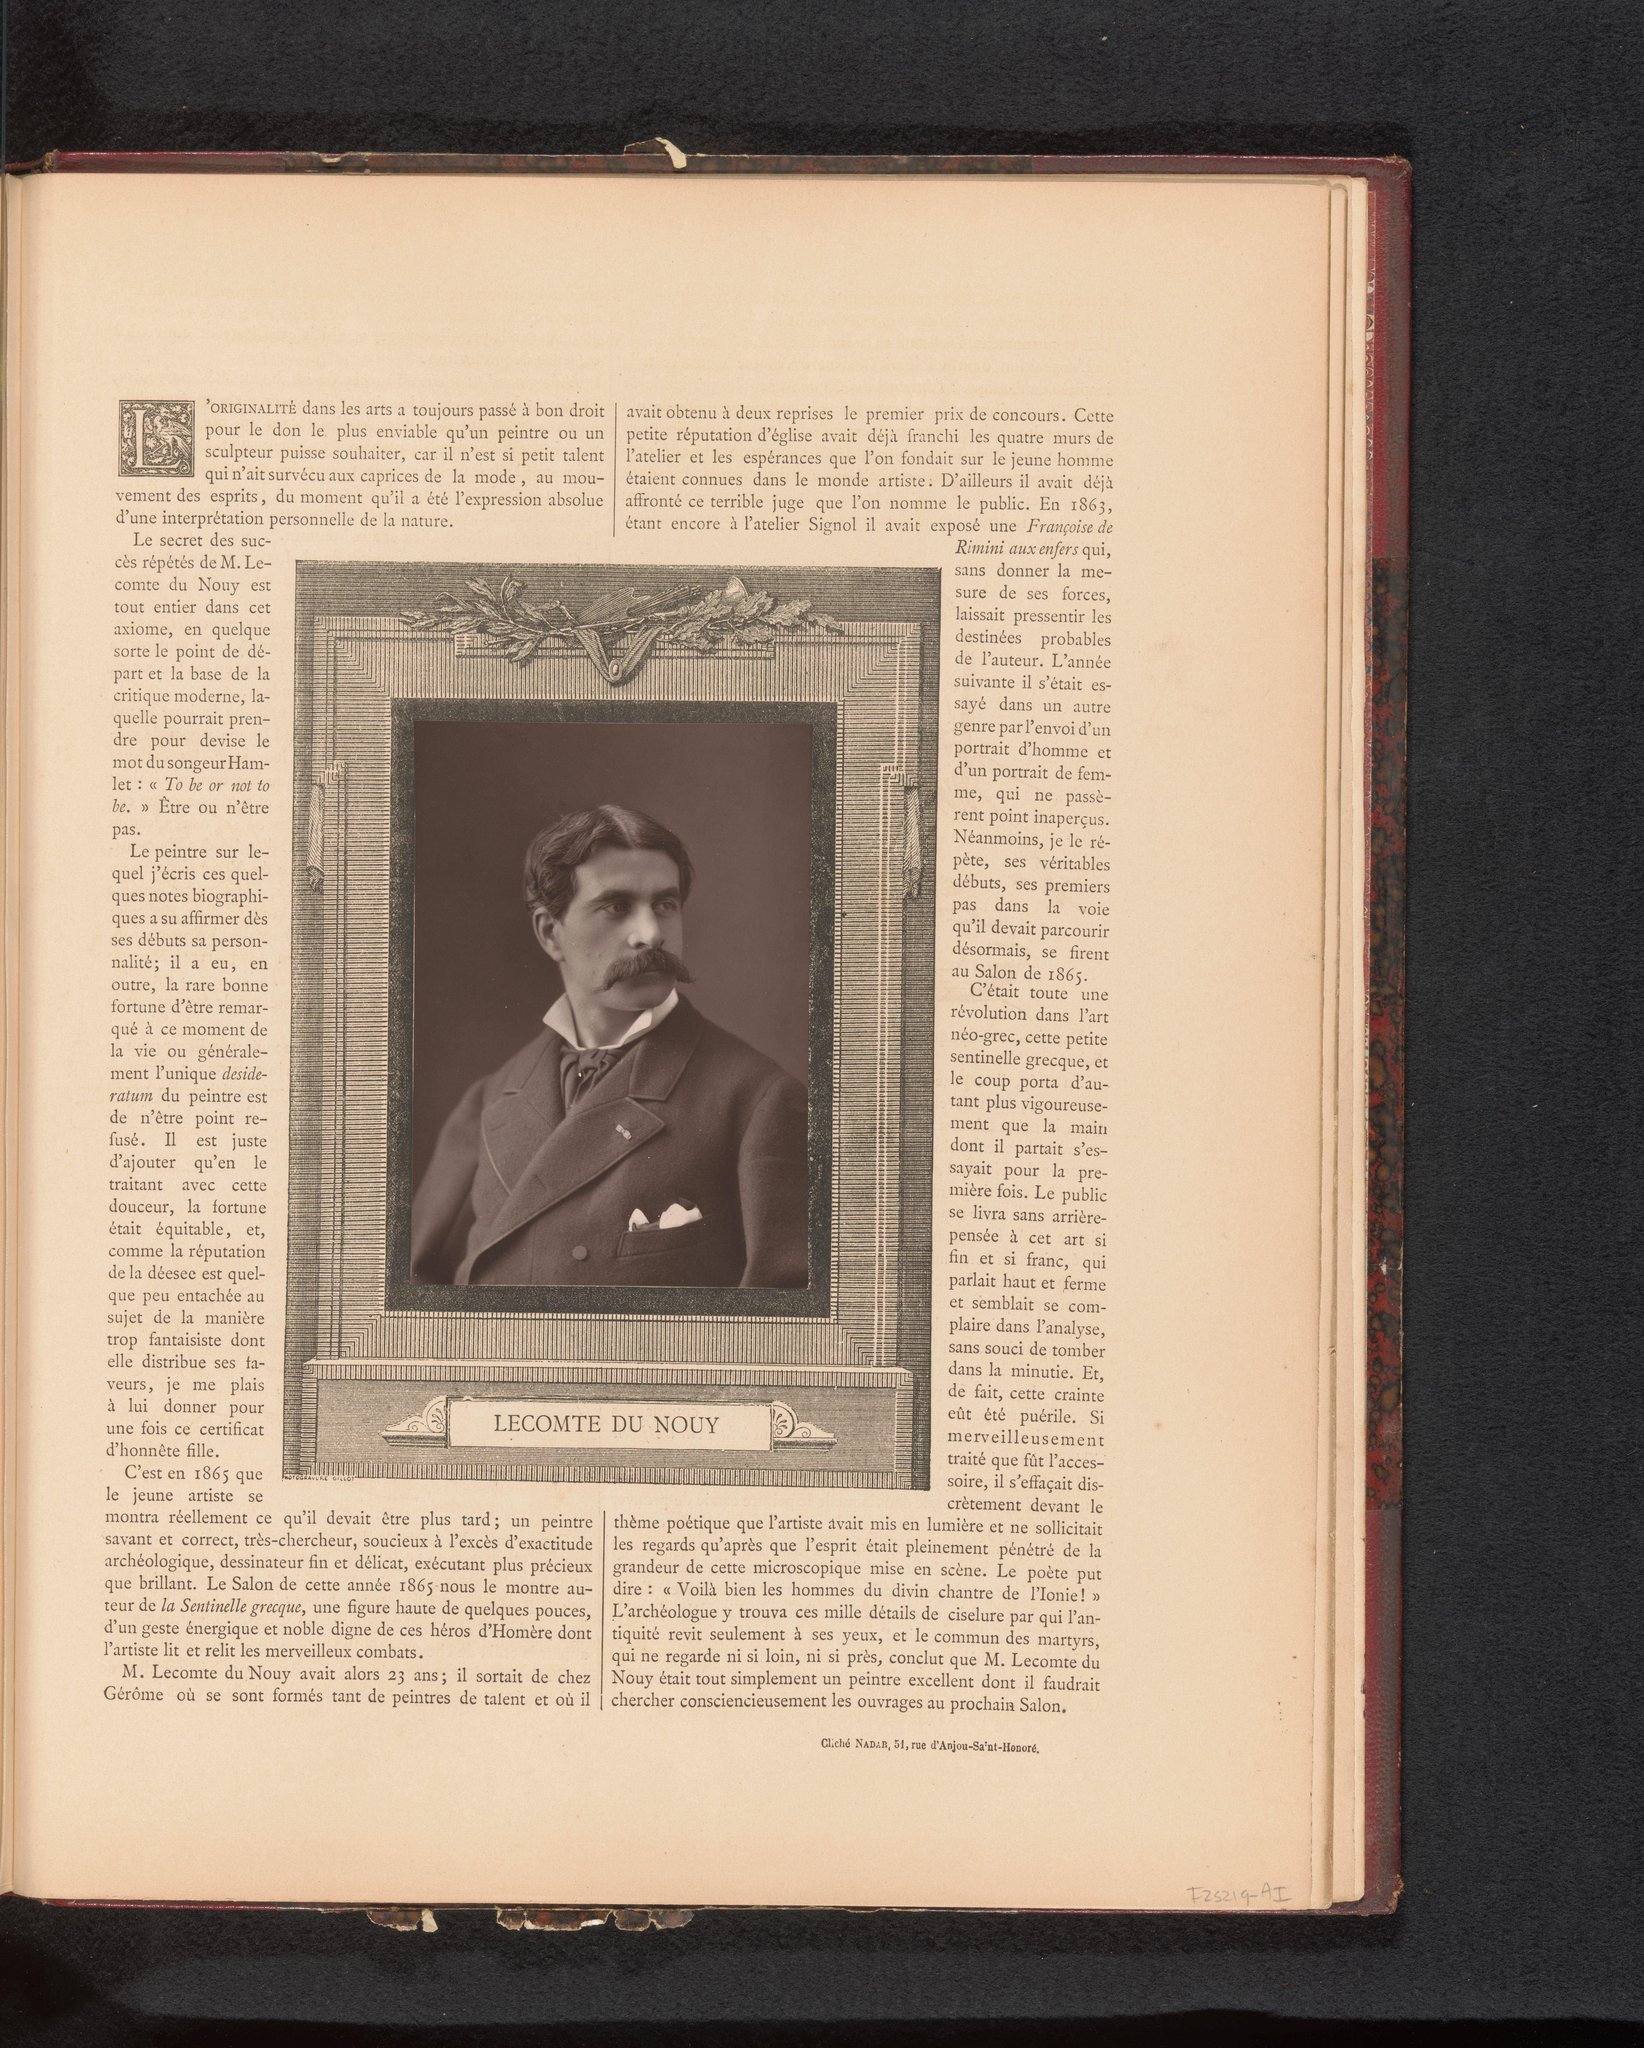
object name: photomechanical print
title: Lecomte du Nouy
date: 1872-1877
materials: paper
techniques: woodburytype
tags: painter, sculptor, jean-jules-antoine lecomte du noüy, adult man, historical persons